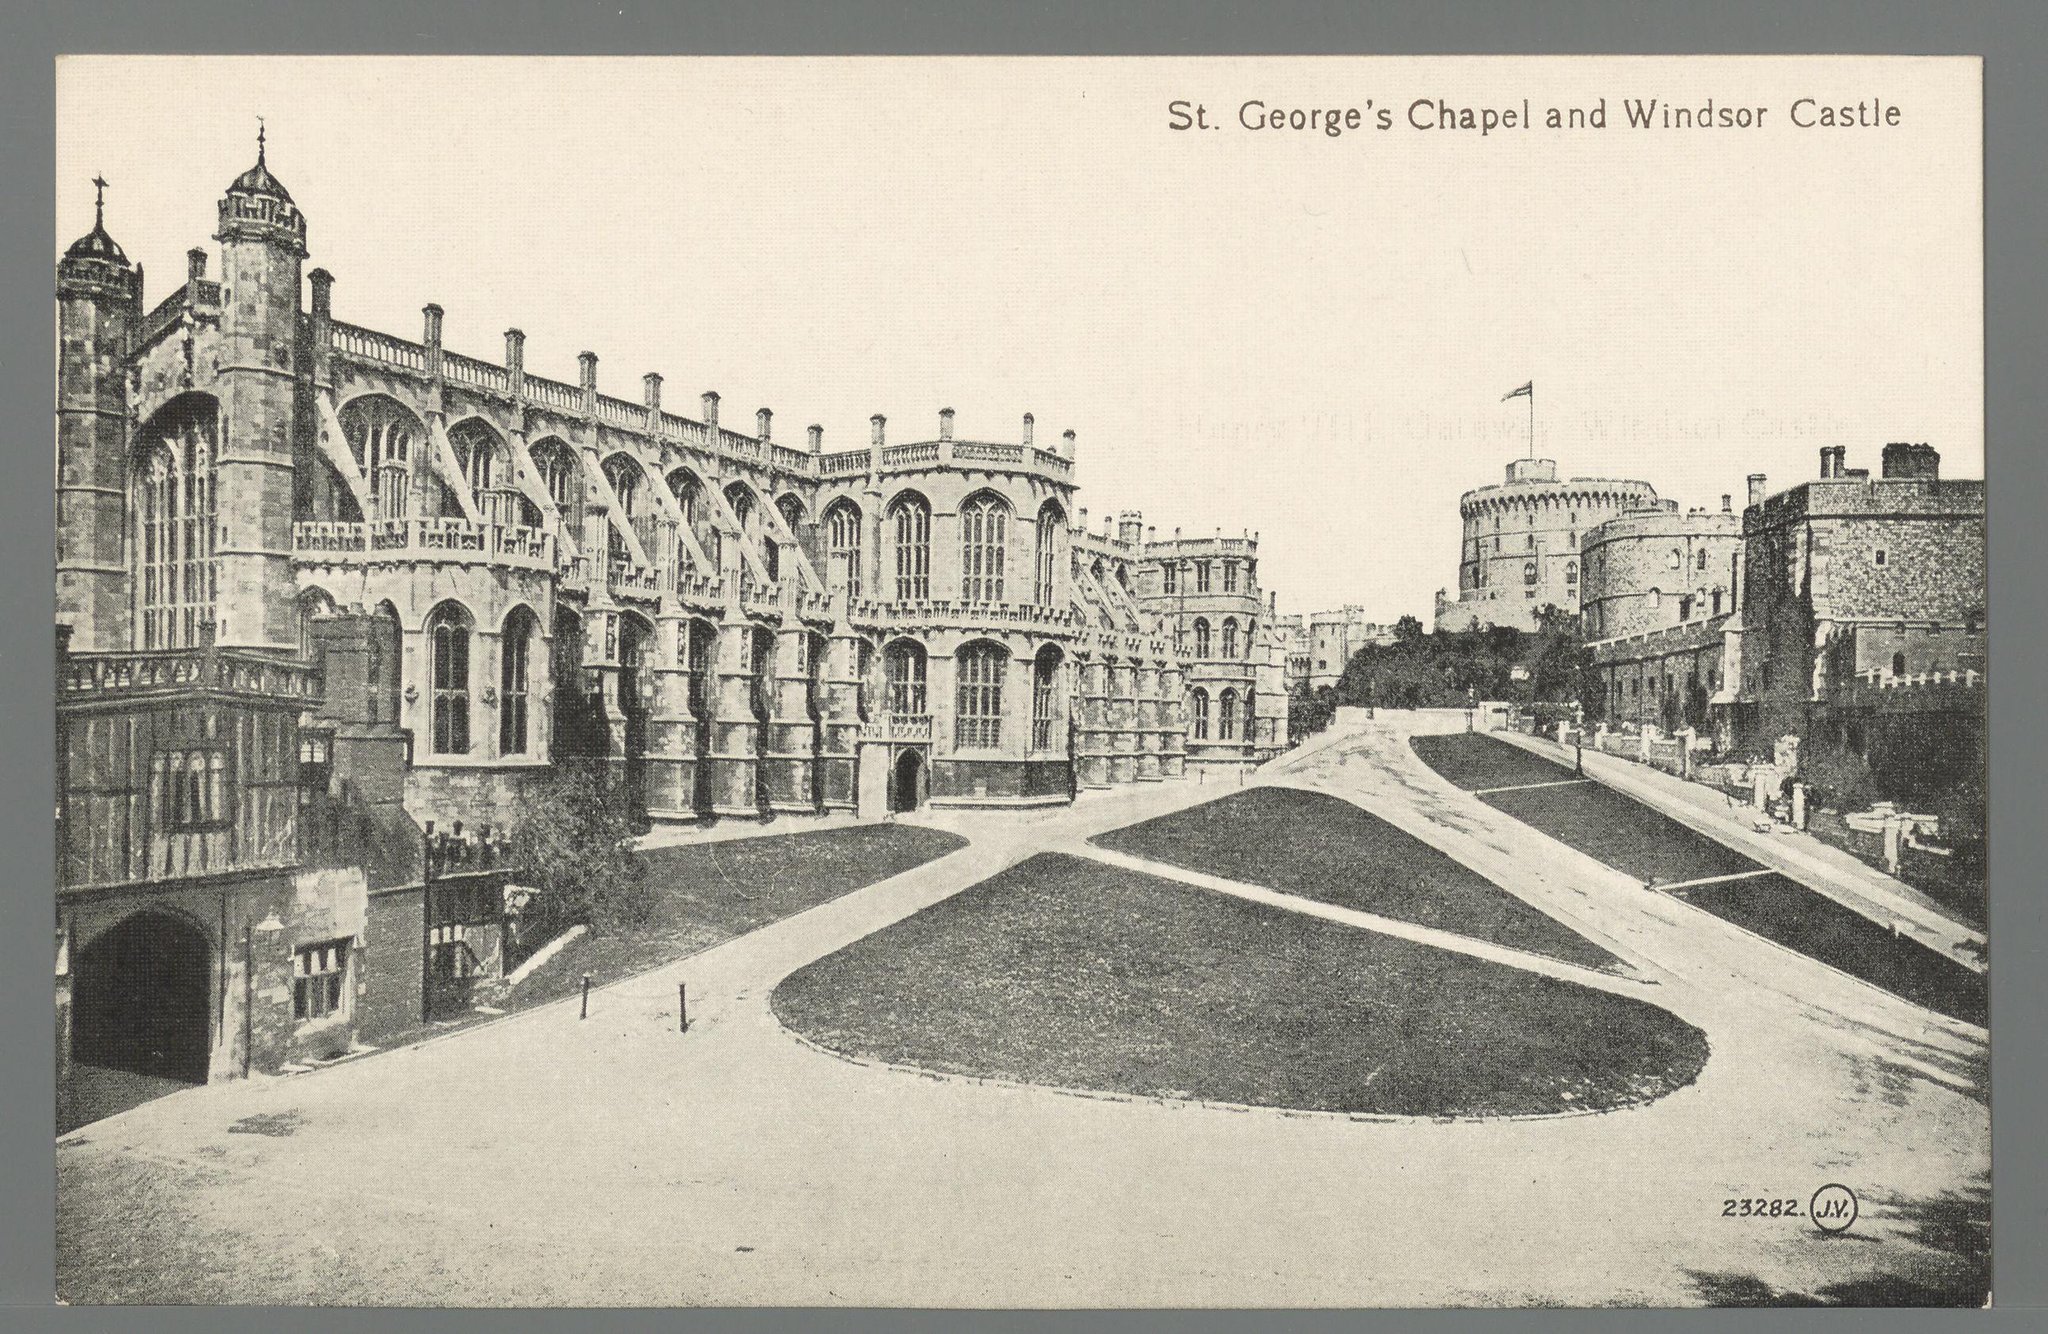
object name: ansichtkaart, prentbriefkaart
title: St. George's Chapel and Windsor Castle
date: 1902-1930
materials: cardboard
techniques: autotype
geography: windsor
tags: castle, church (exterior) - qq - small church, chapel